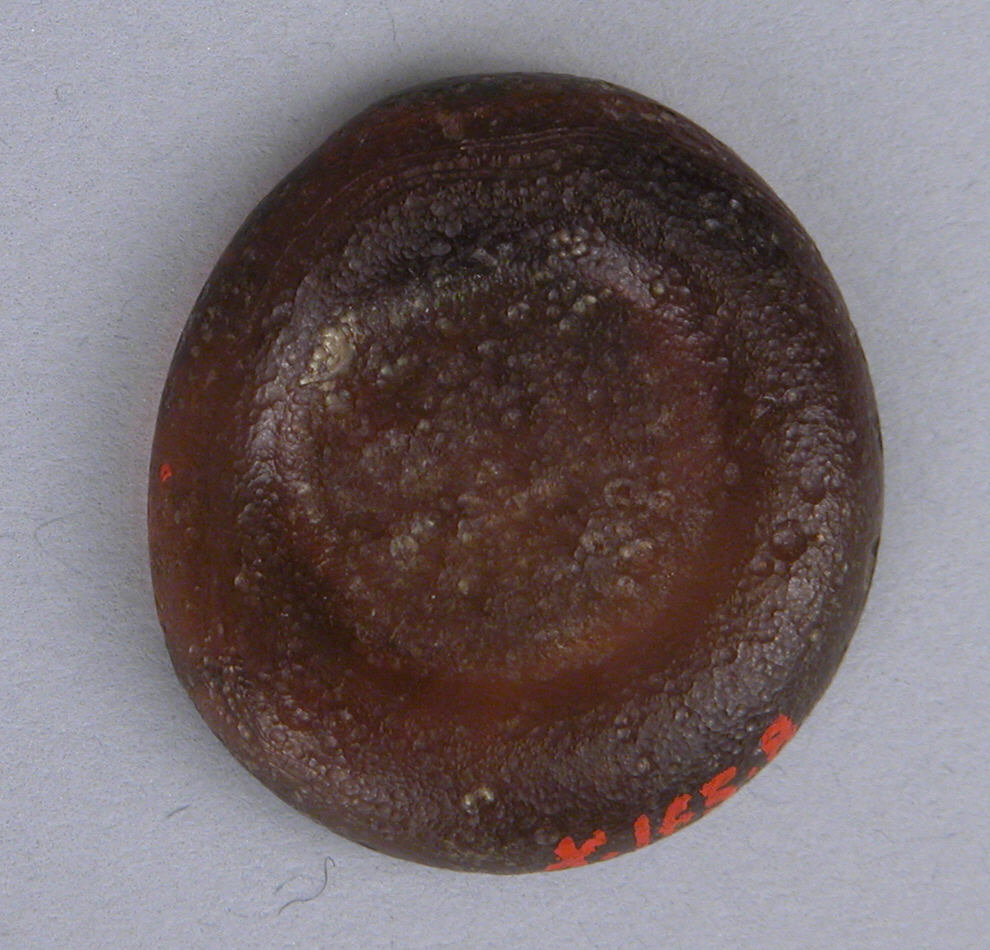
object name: coin weight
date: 1201-1600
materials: glass